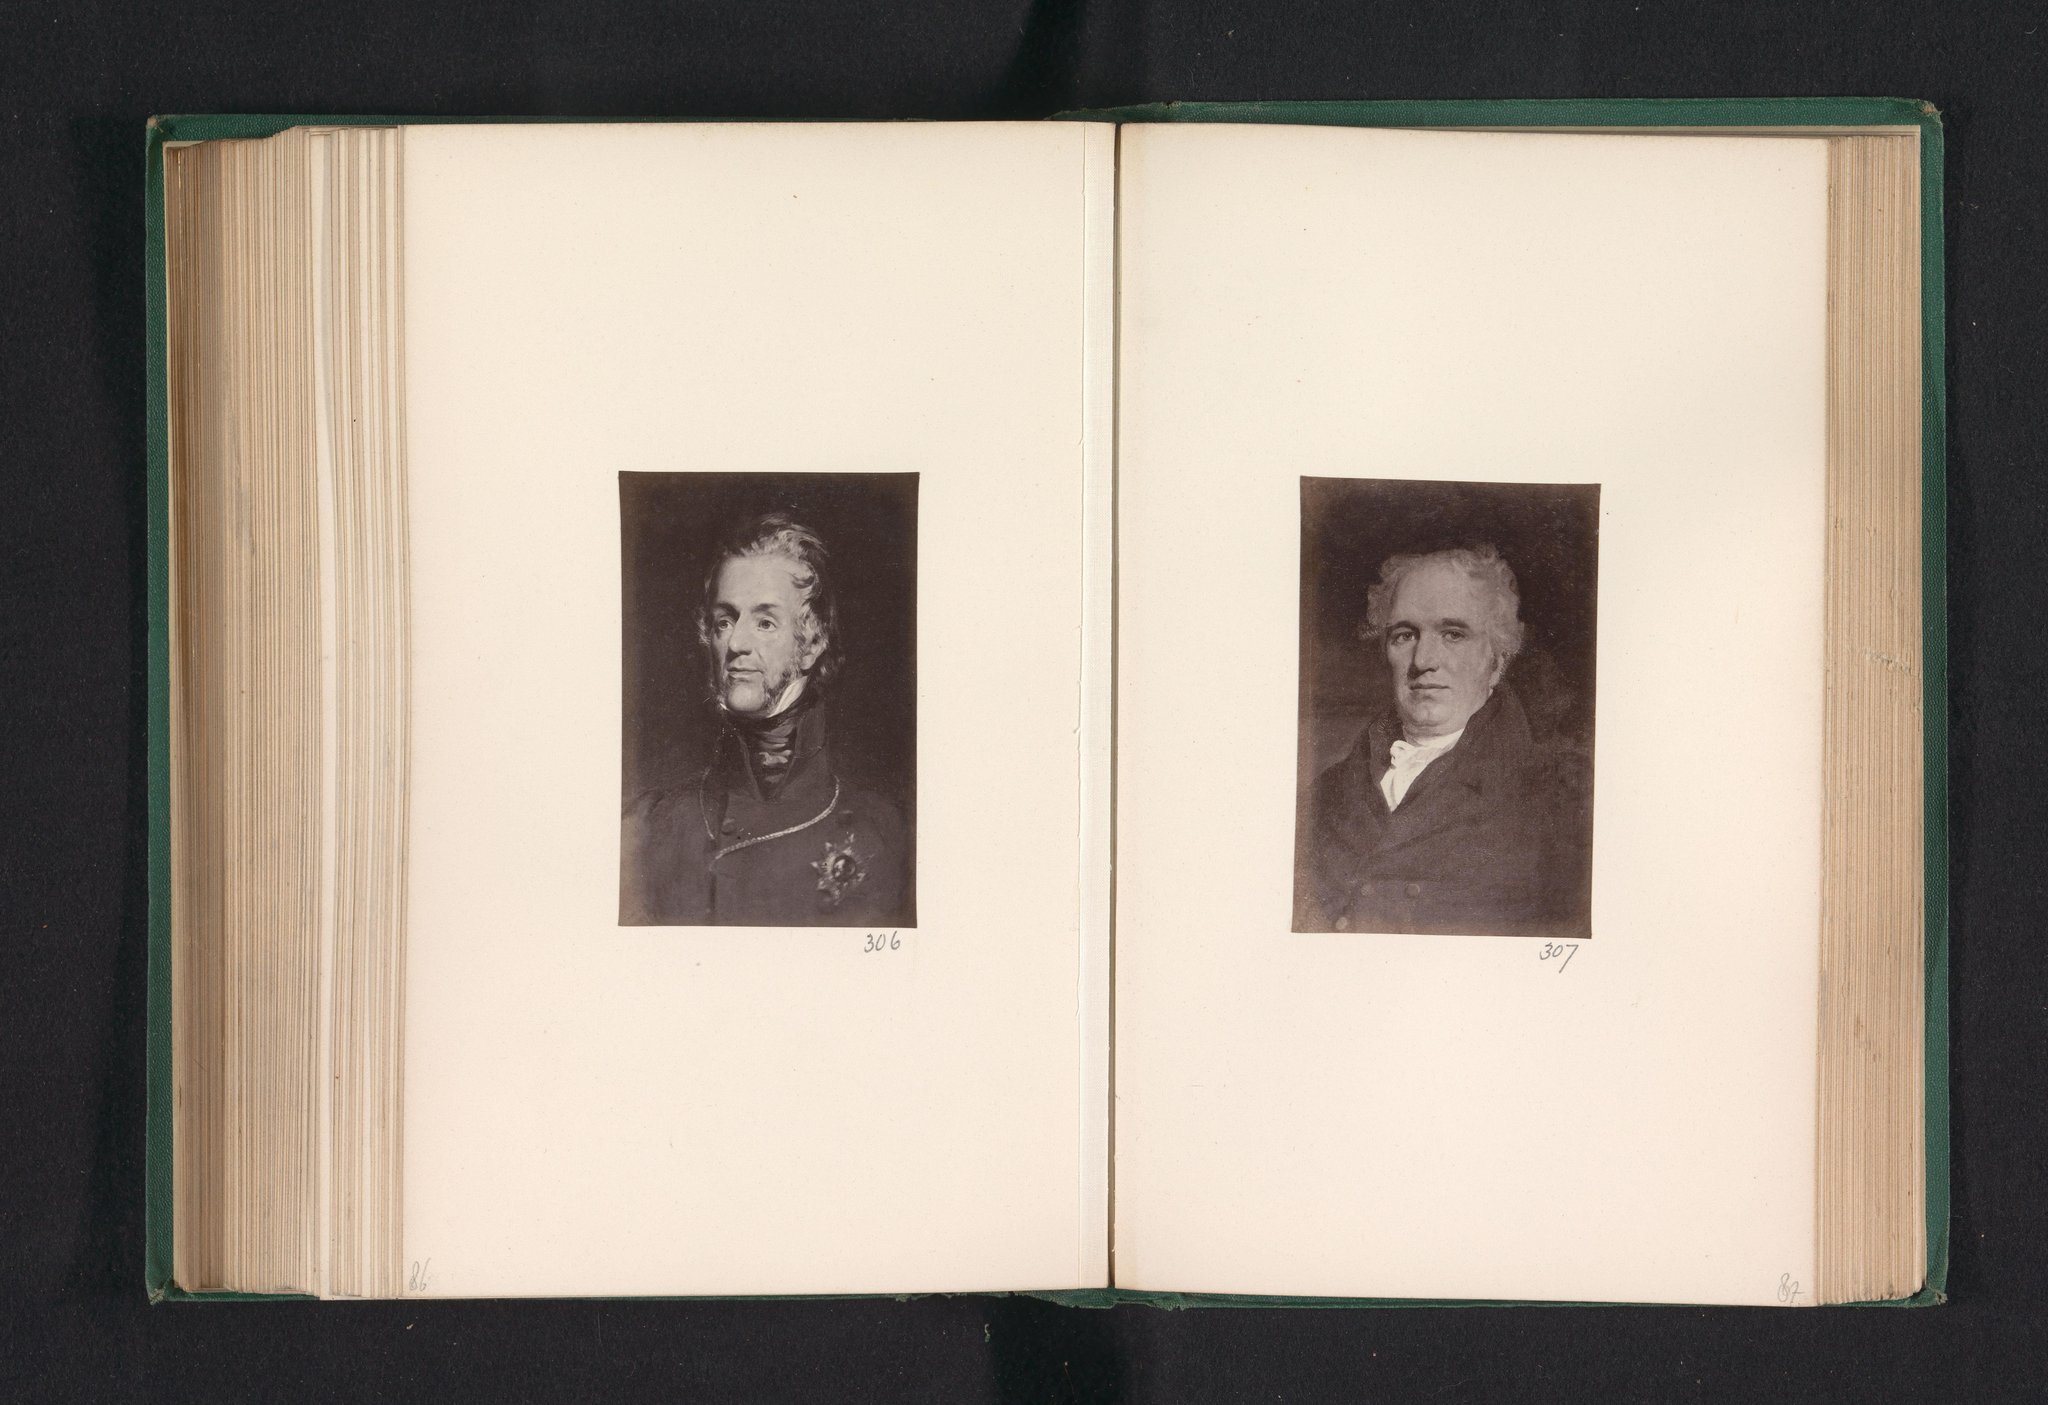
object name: page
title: Fotoreproductie van een schilderij, voorstellende een portret van Alexander Hamilton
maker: thomas annan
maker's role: fotograaf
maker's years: 1829-1887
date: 1863-1868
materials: photographic support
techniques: albumen print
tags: politician, historical persons (portraits and scenes from the life) (+ (full) bust portrait)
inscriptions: number: ‘306’